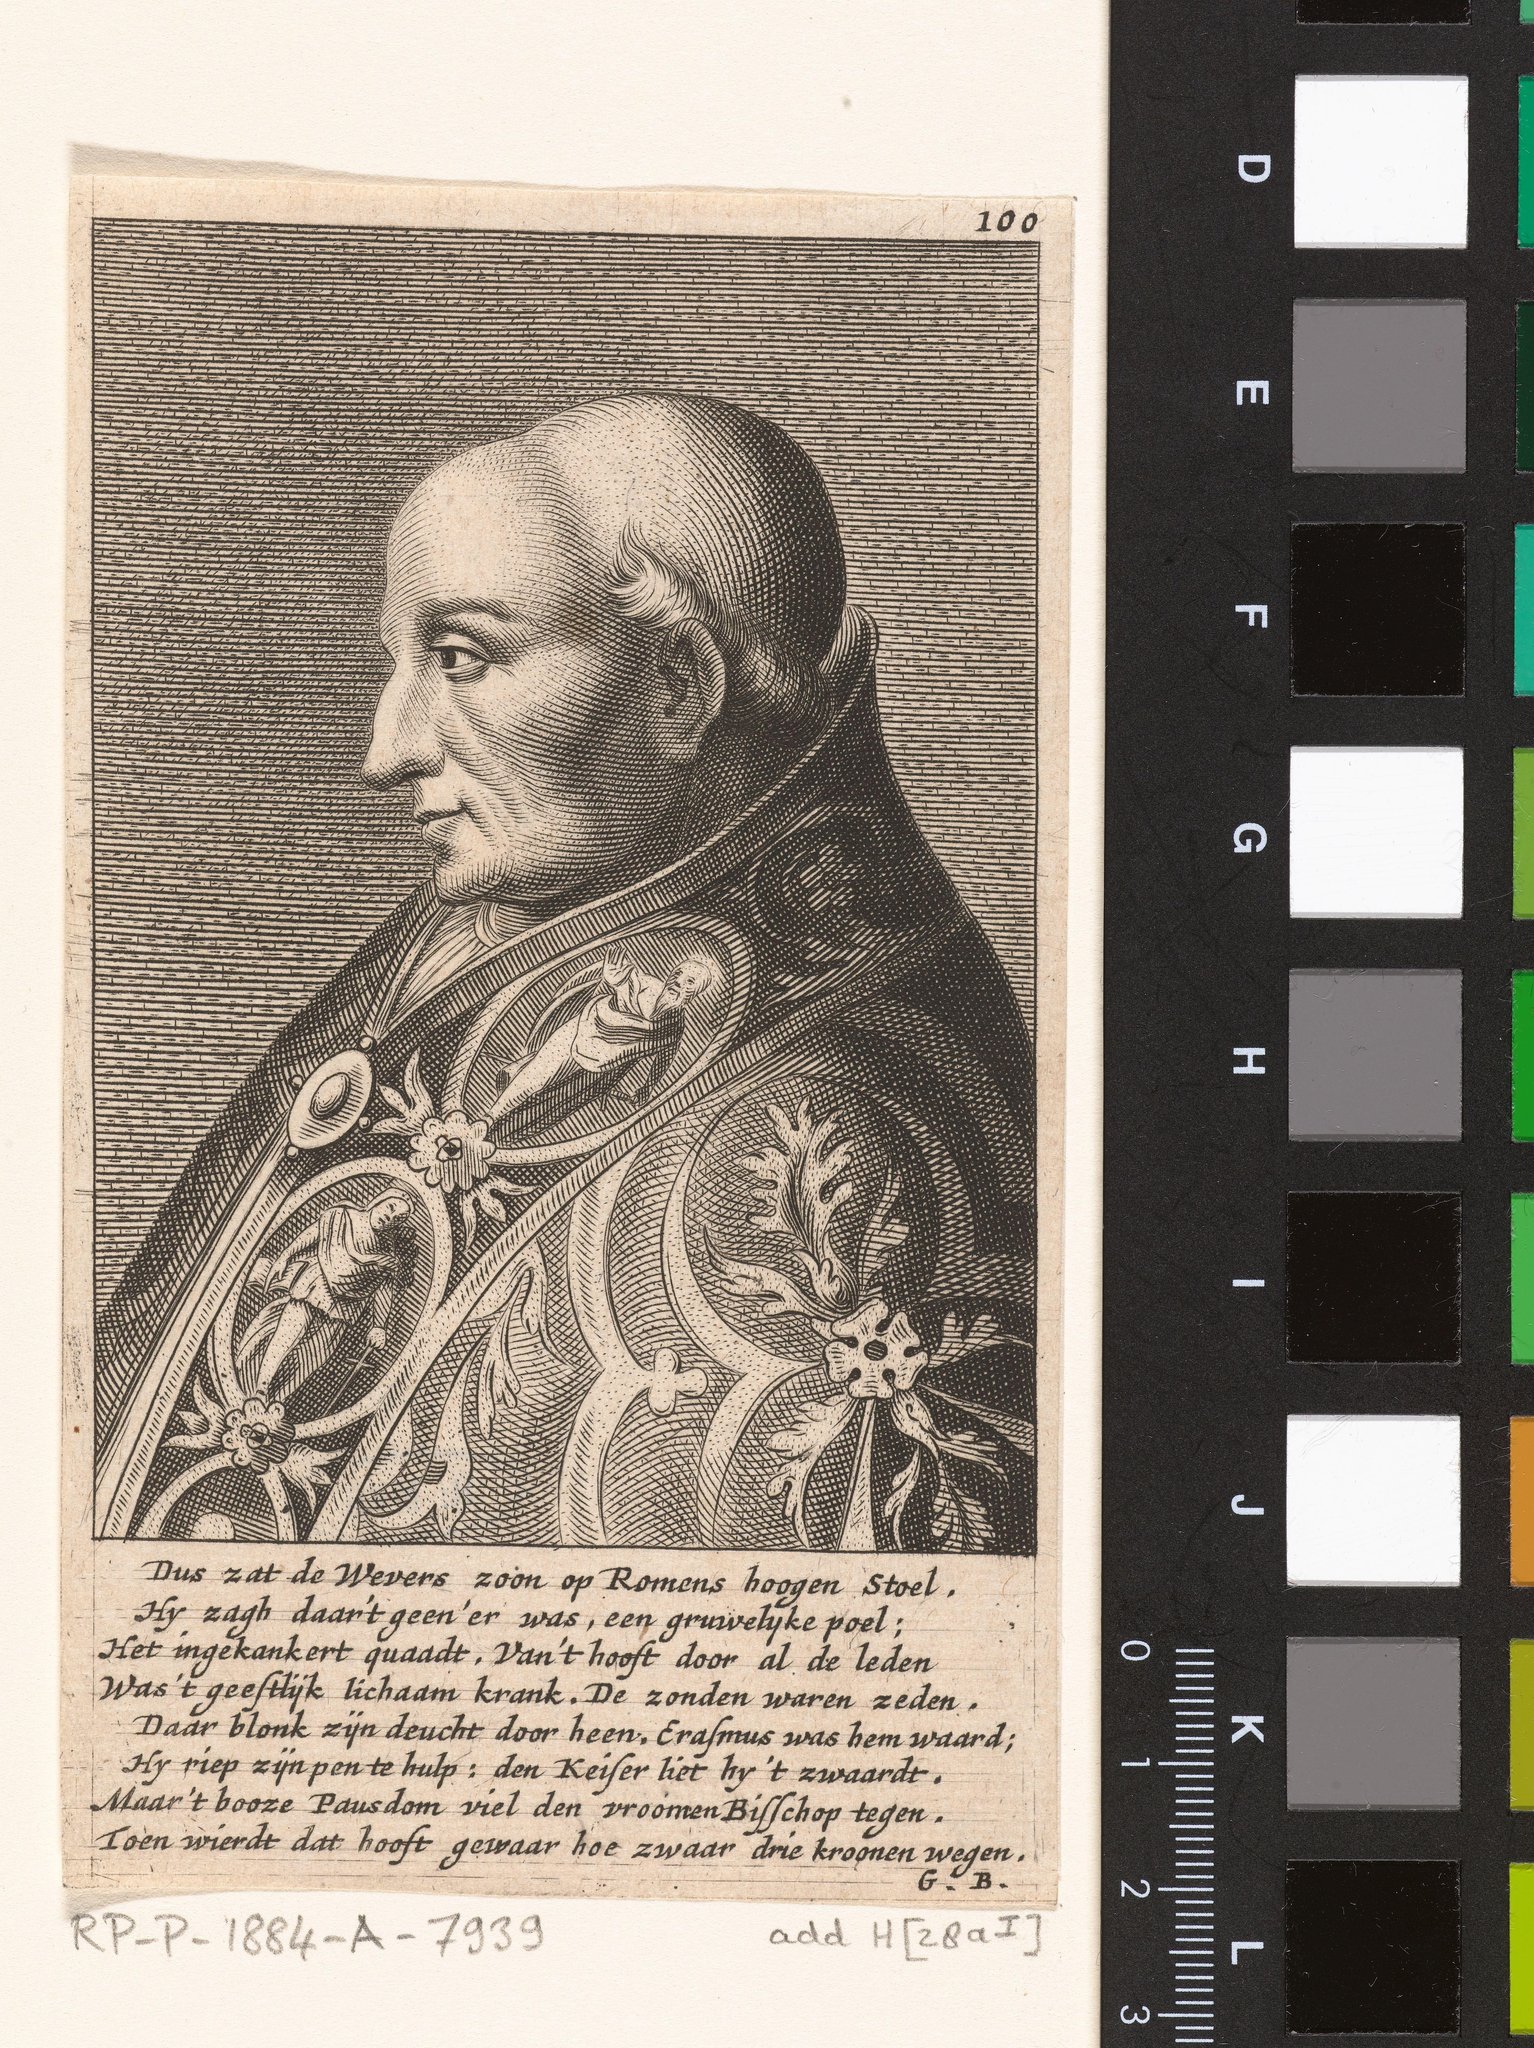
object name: print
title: Portret van paus Adrianus VI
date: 1657-1707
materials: paper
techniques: engraving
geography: netherlands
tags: rome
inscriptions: collector's mark: Lugt 2228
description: Portretbuste van paus Adrianus VI met een rijk versierde mantel aan. Onder de voorstelling een vers van acht regels in het Nederlands.